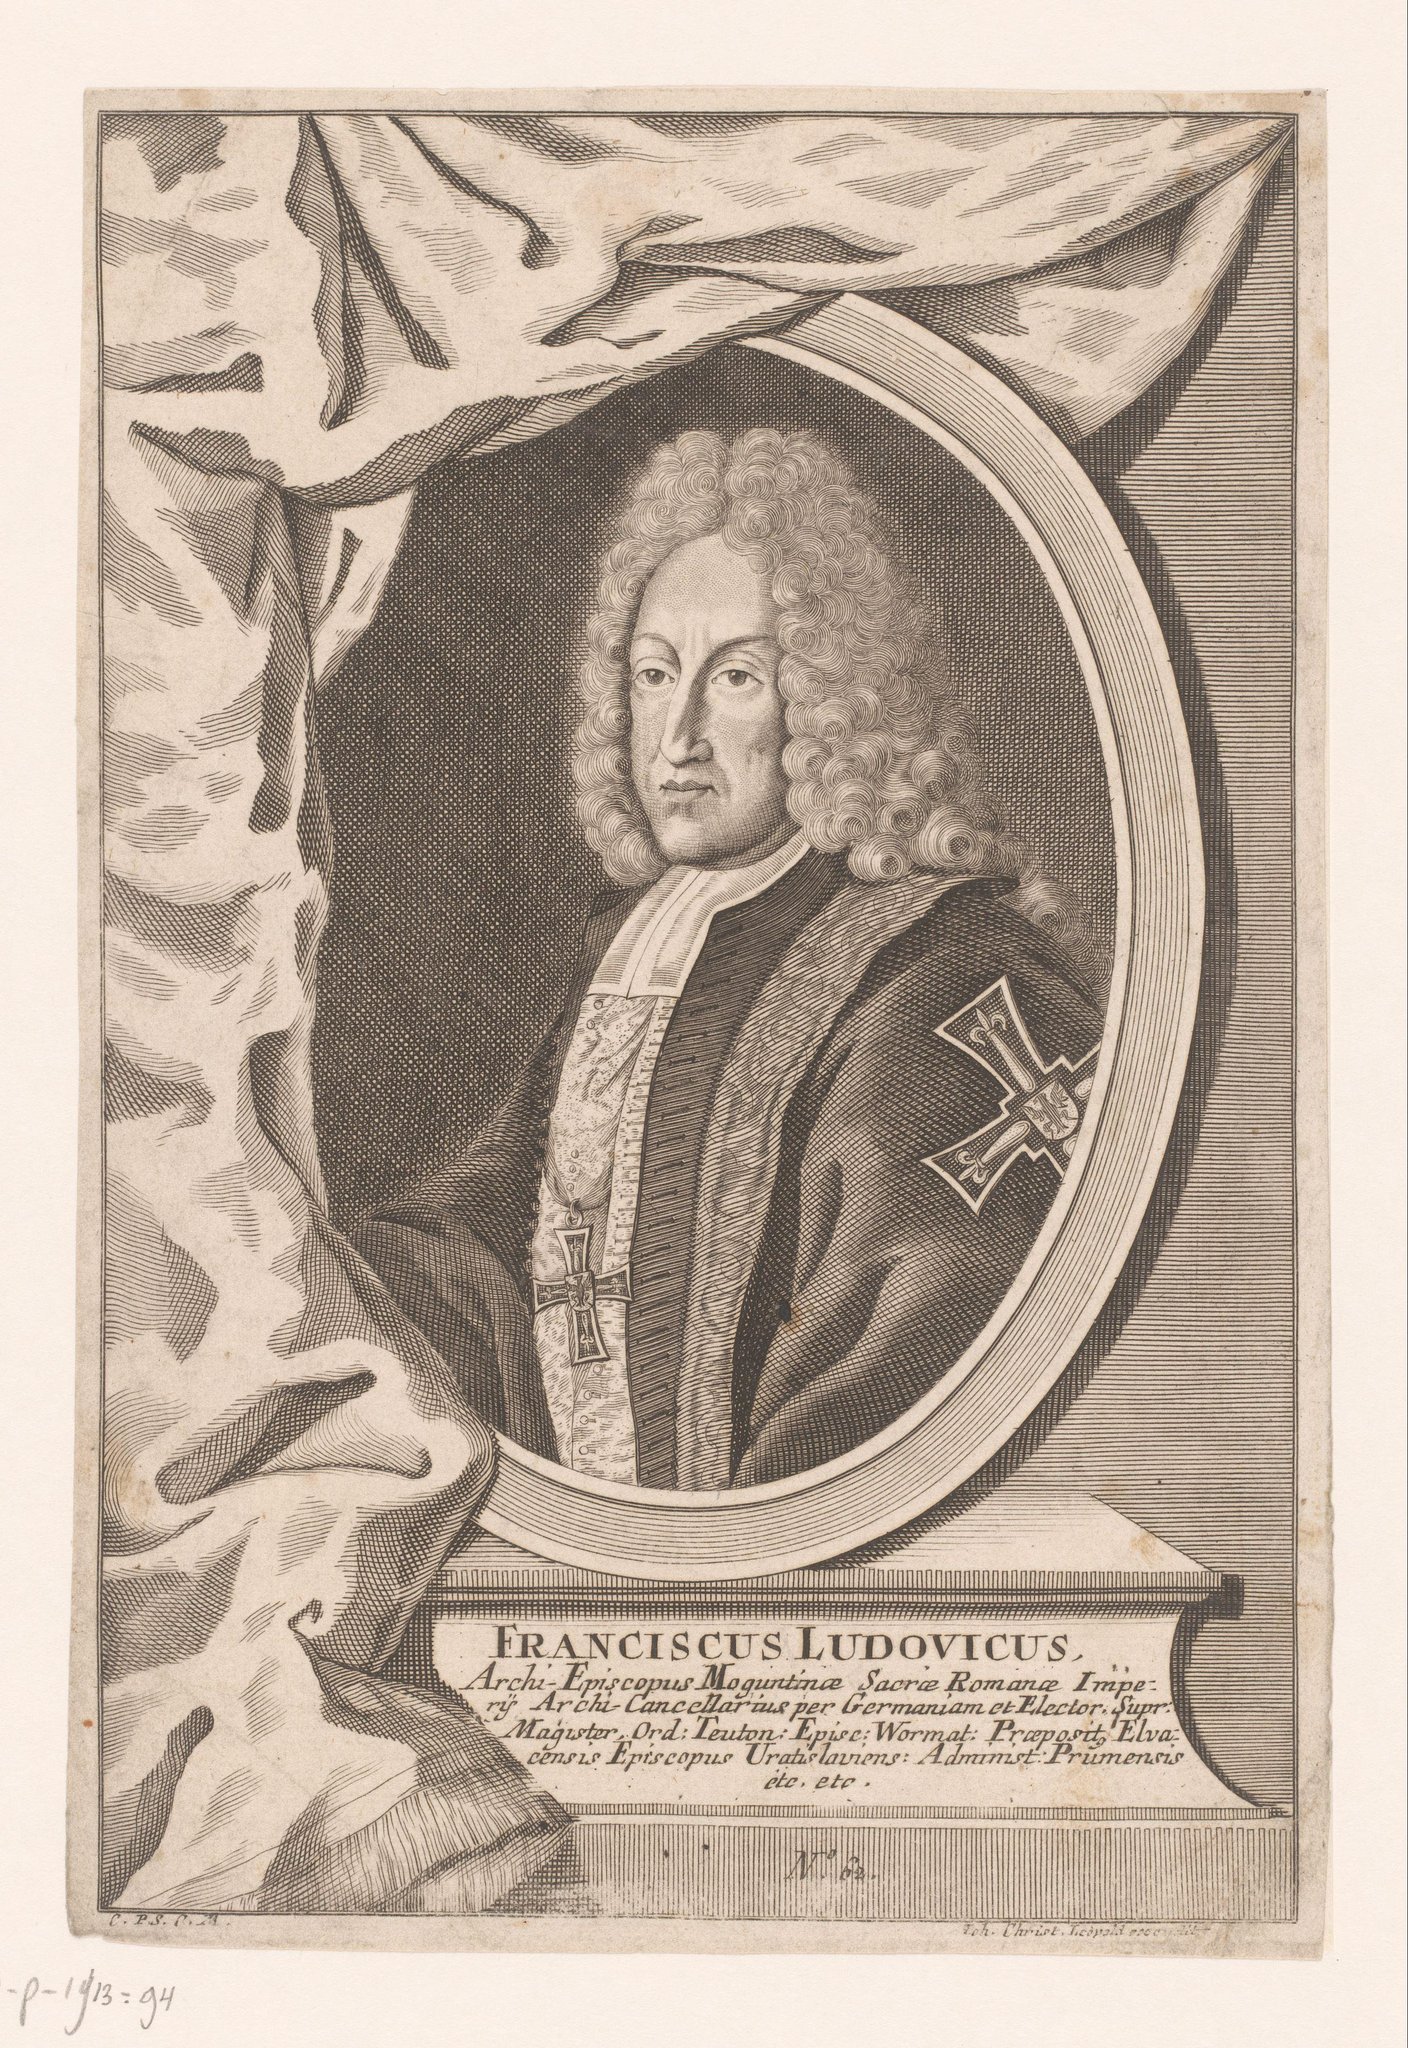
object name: print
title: Portret van Franz Ludwig von Pfalz-Neuburg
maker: johann christian leopold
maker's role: print maker, publisher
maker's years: 1699-1755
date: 1709-1755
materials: paper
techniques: engraving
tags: historical persons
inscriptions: collector's mark: Lugt 2228